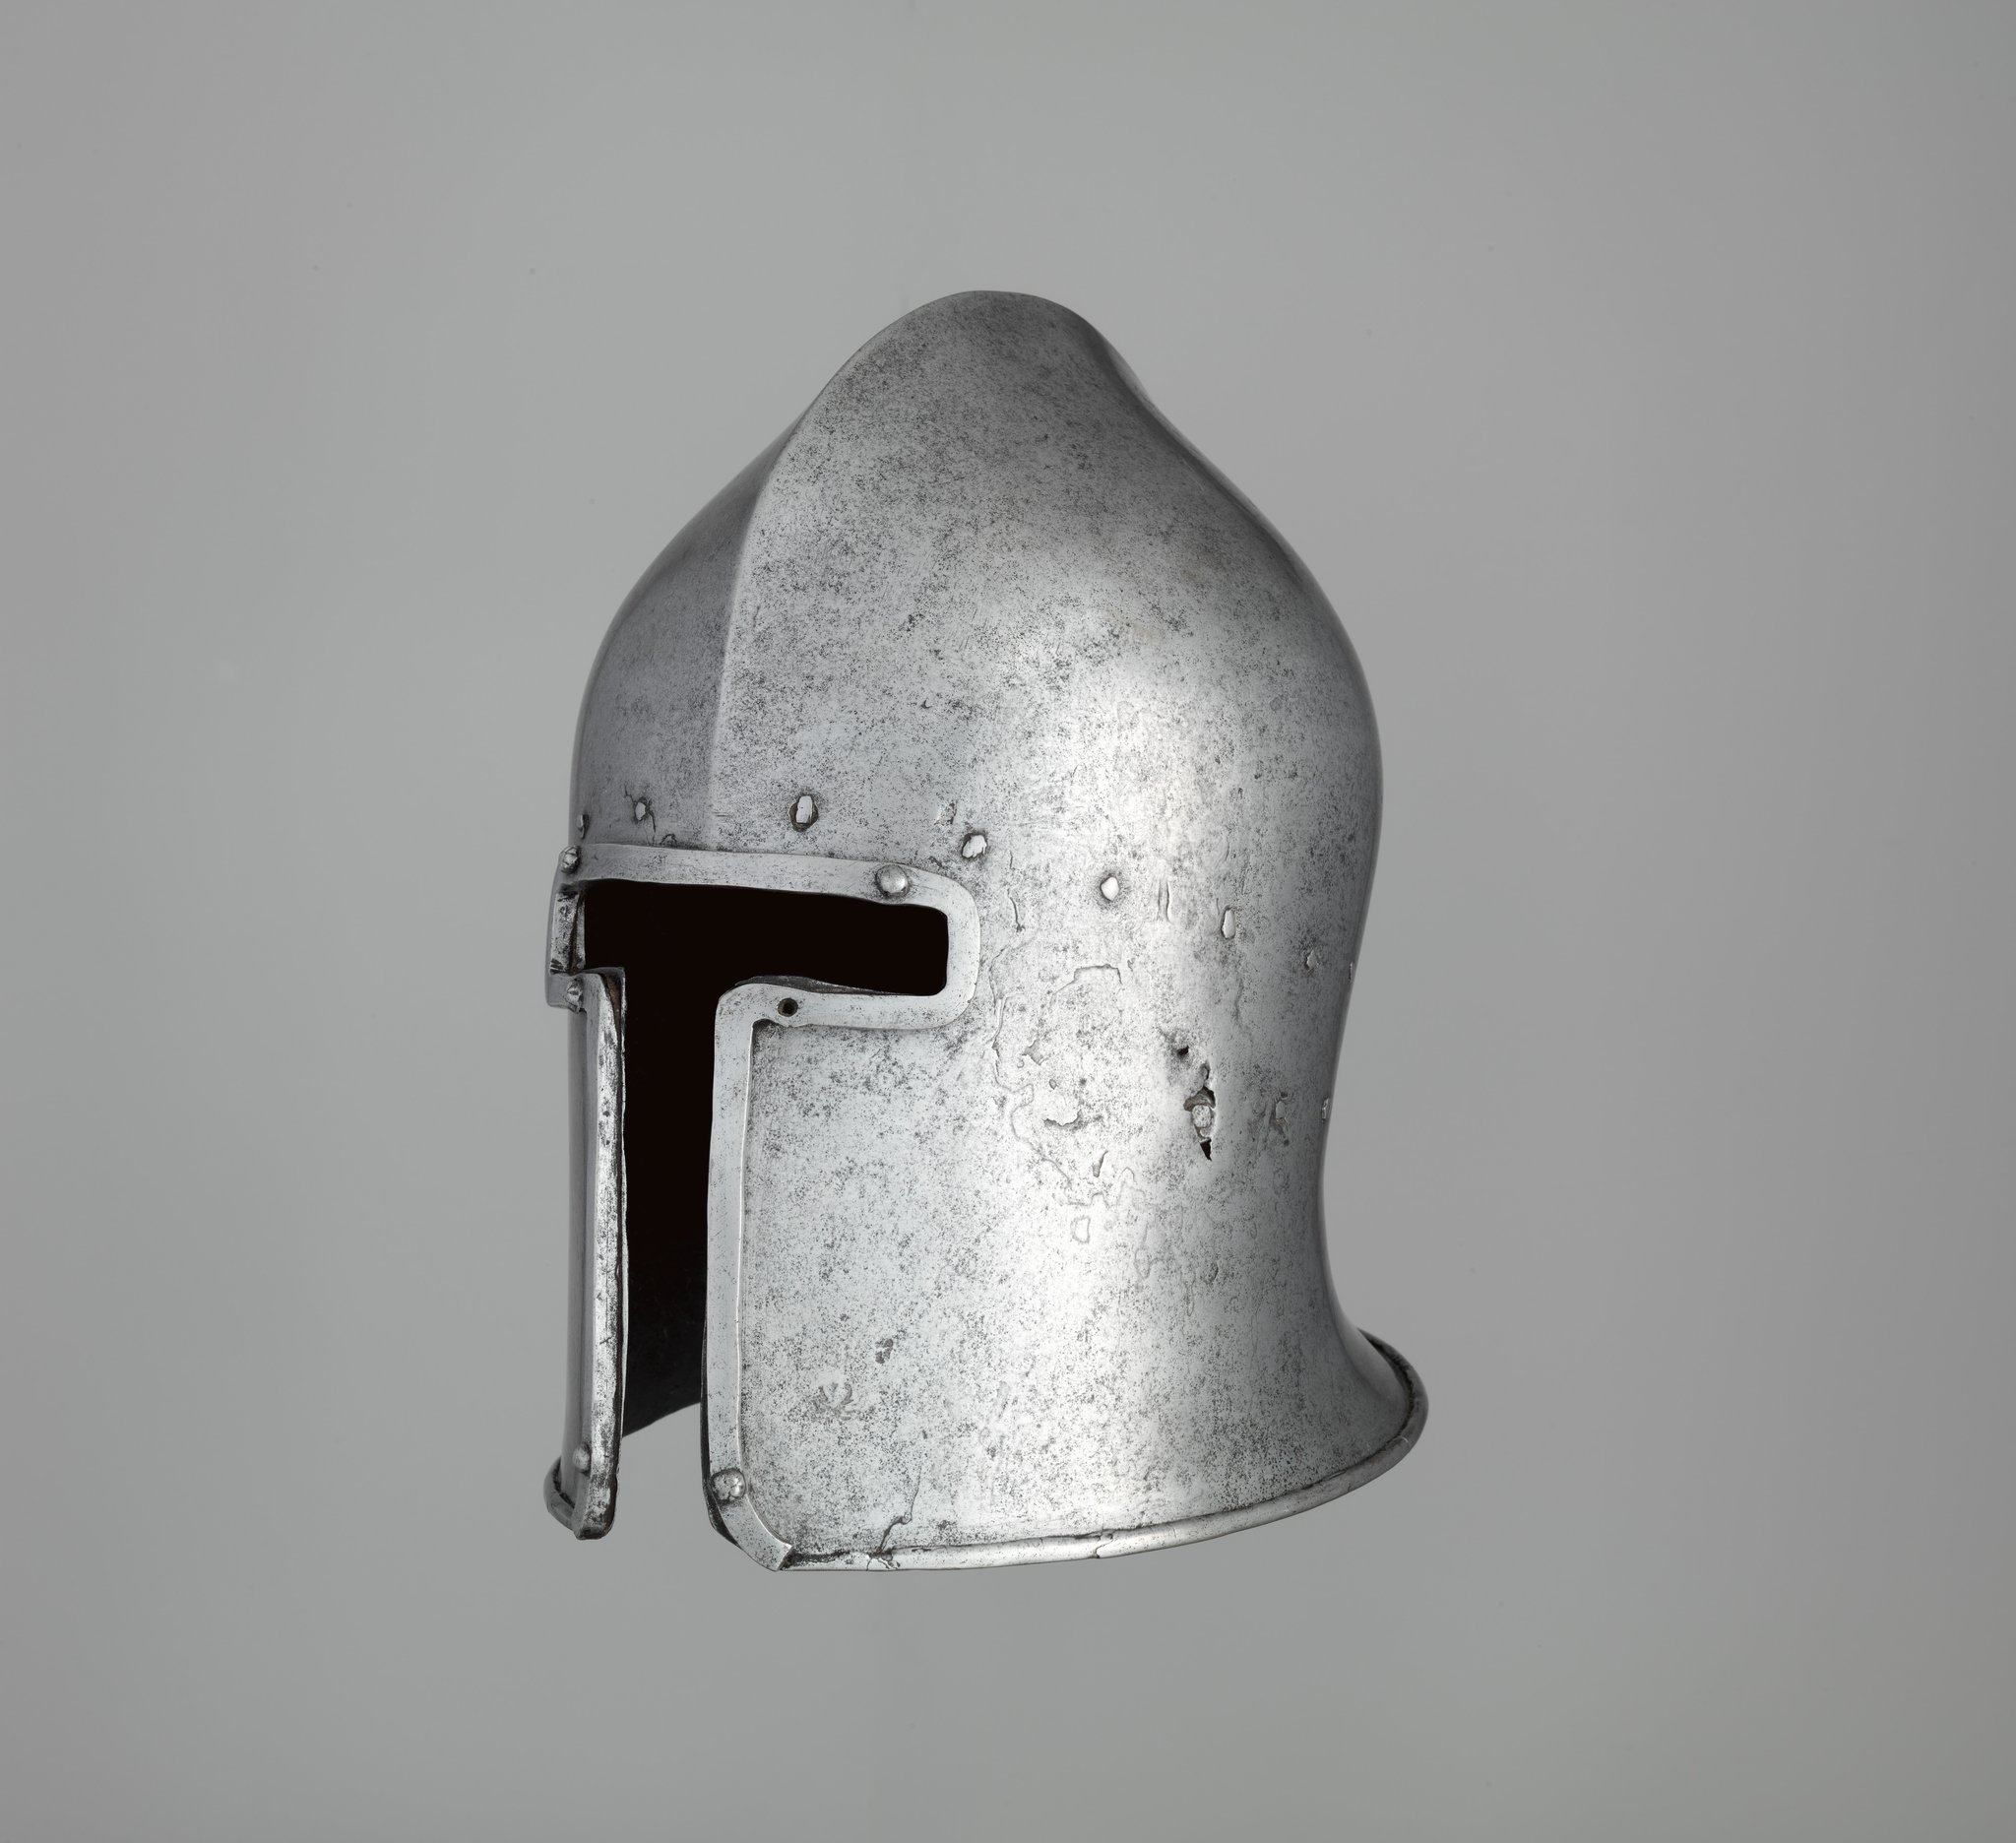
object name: barbute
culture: italian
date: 1460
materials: steel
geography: italy